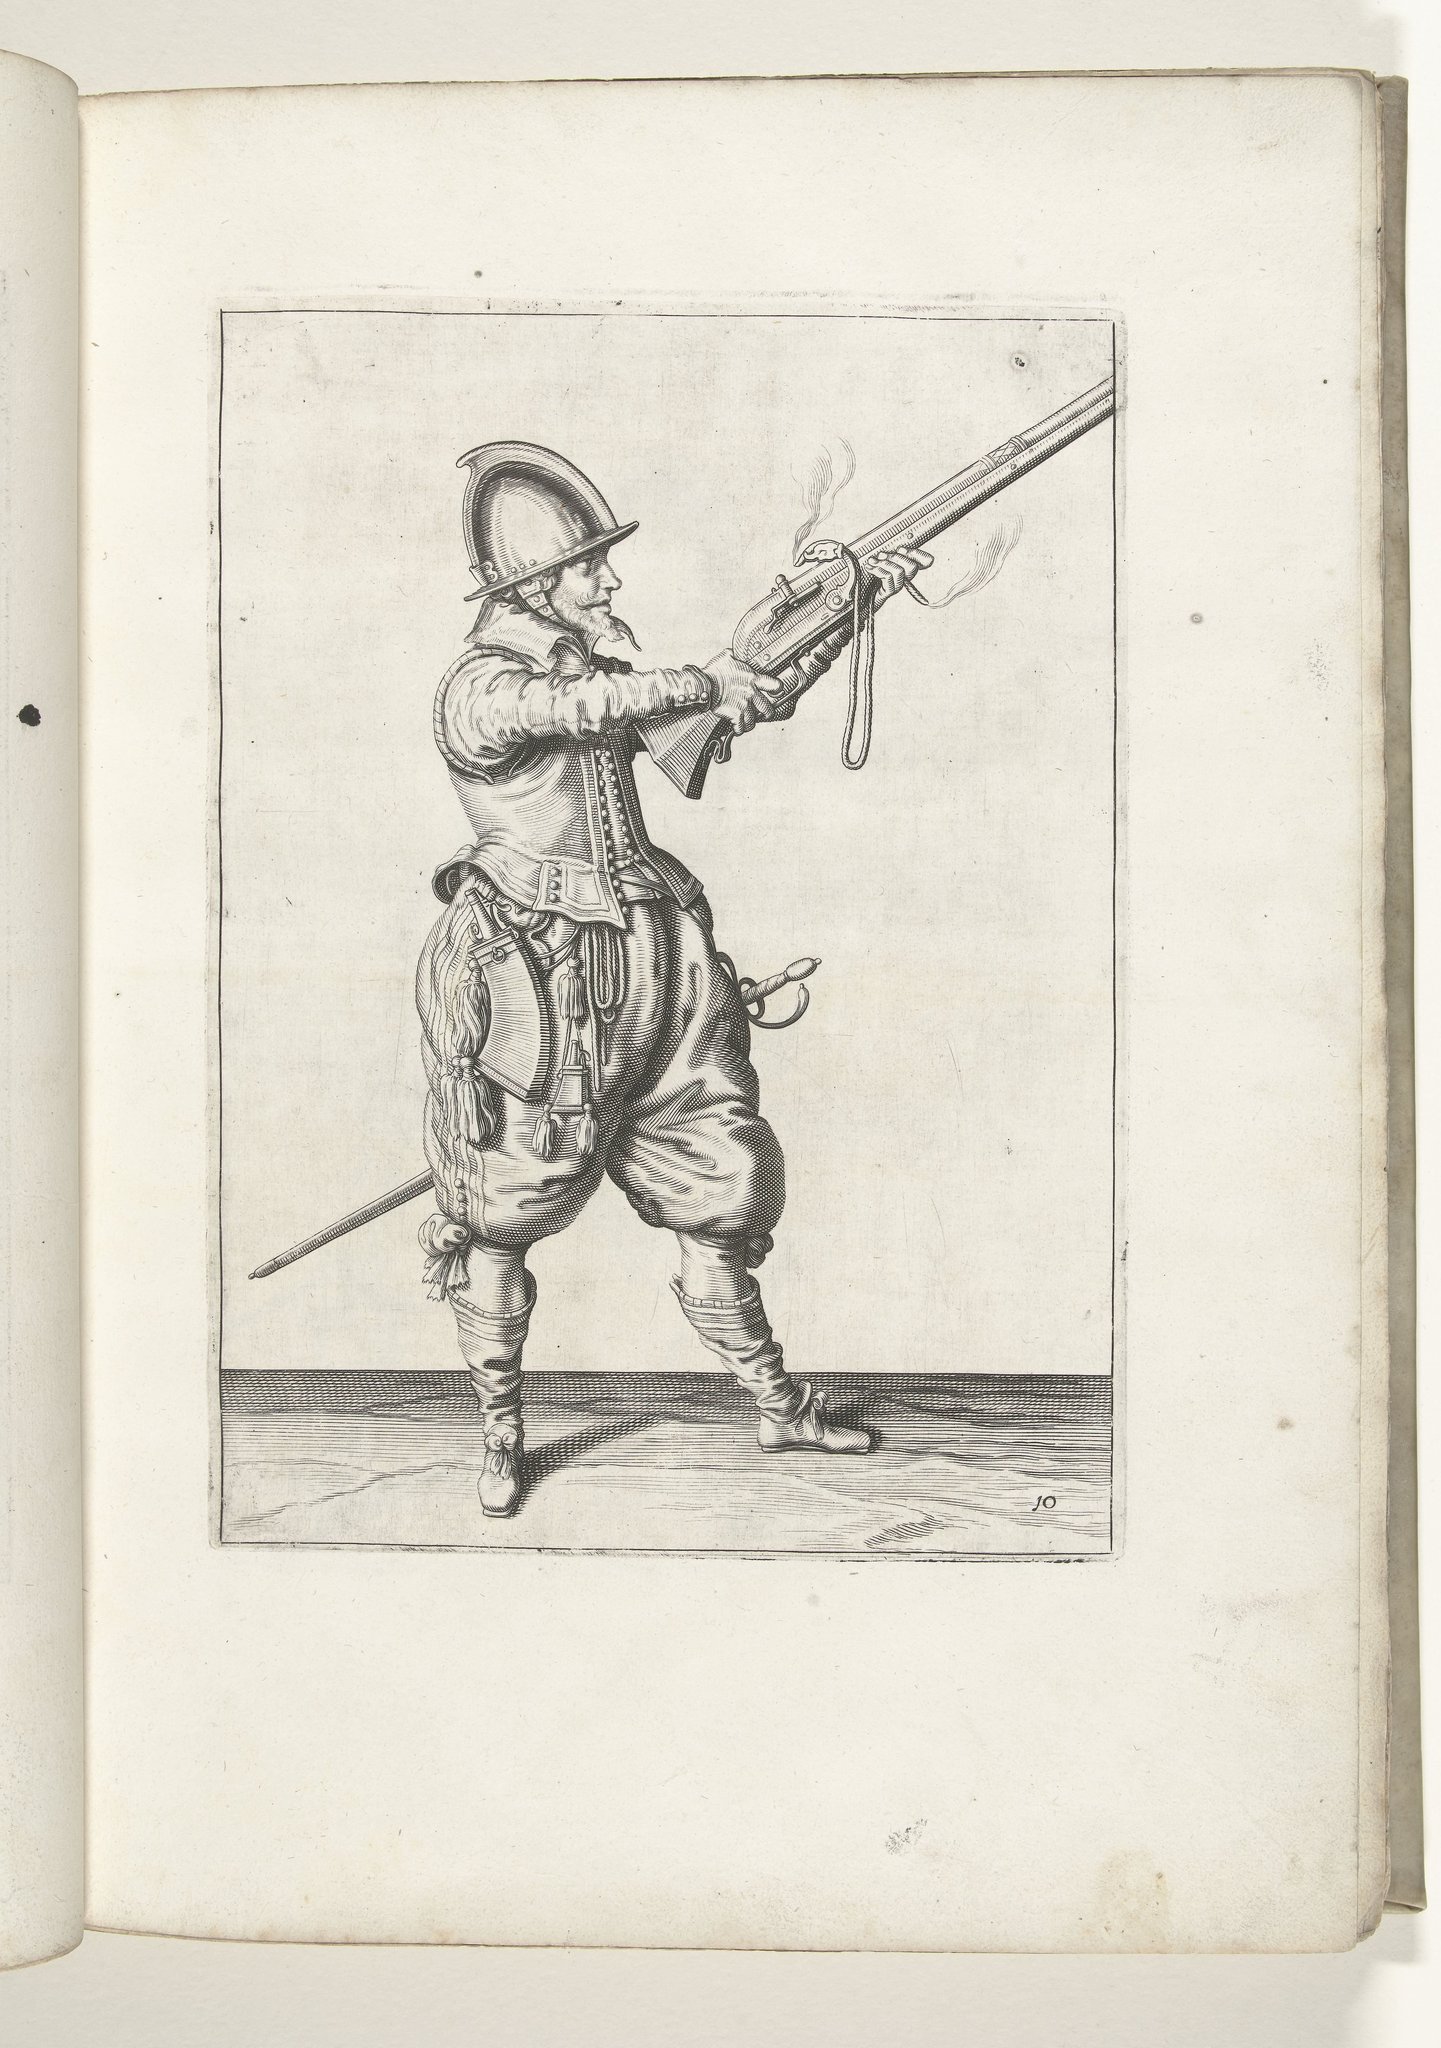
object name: print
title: Soldaat richt de roer met beide handen omhoog (nr. 10), ca. 1600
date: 1597-1607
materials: paper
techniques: engraving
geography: northern netherlands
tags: the hague, maurice (prince of orange), handling of weapons ~ military training, weapons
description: Een soldaat, ten voeten uit, naar rechts, die een roer (een bepaald type vuurwapen) met beide handen vasthoudt en deze schuin omhoog richt (nr. 10), ca. 1600. Plaat 10 in de instructies voor het hanteren van de roer: Corte onderwysinghe op de figuerliicke afbeeldinghe, belanghende t'rechte ghebruyck des Roers. Onderdeel van de illustraties in: J. de Gheyn, Wapenhandelinghe van Roers Musquetten ende spiessen, 's-Gravenhage, 1607. Krijgswezen rond 1600.